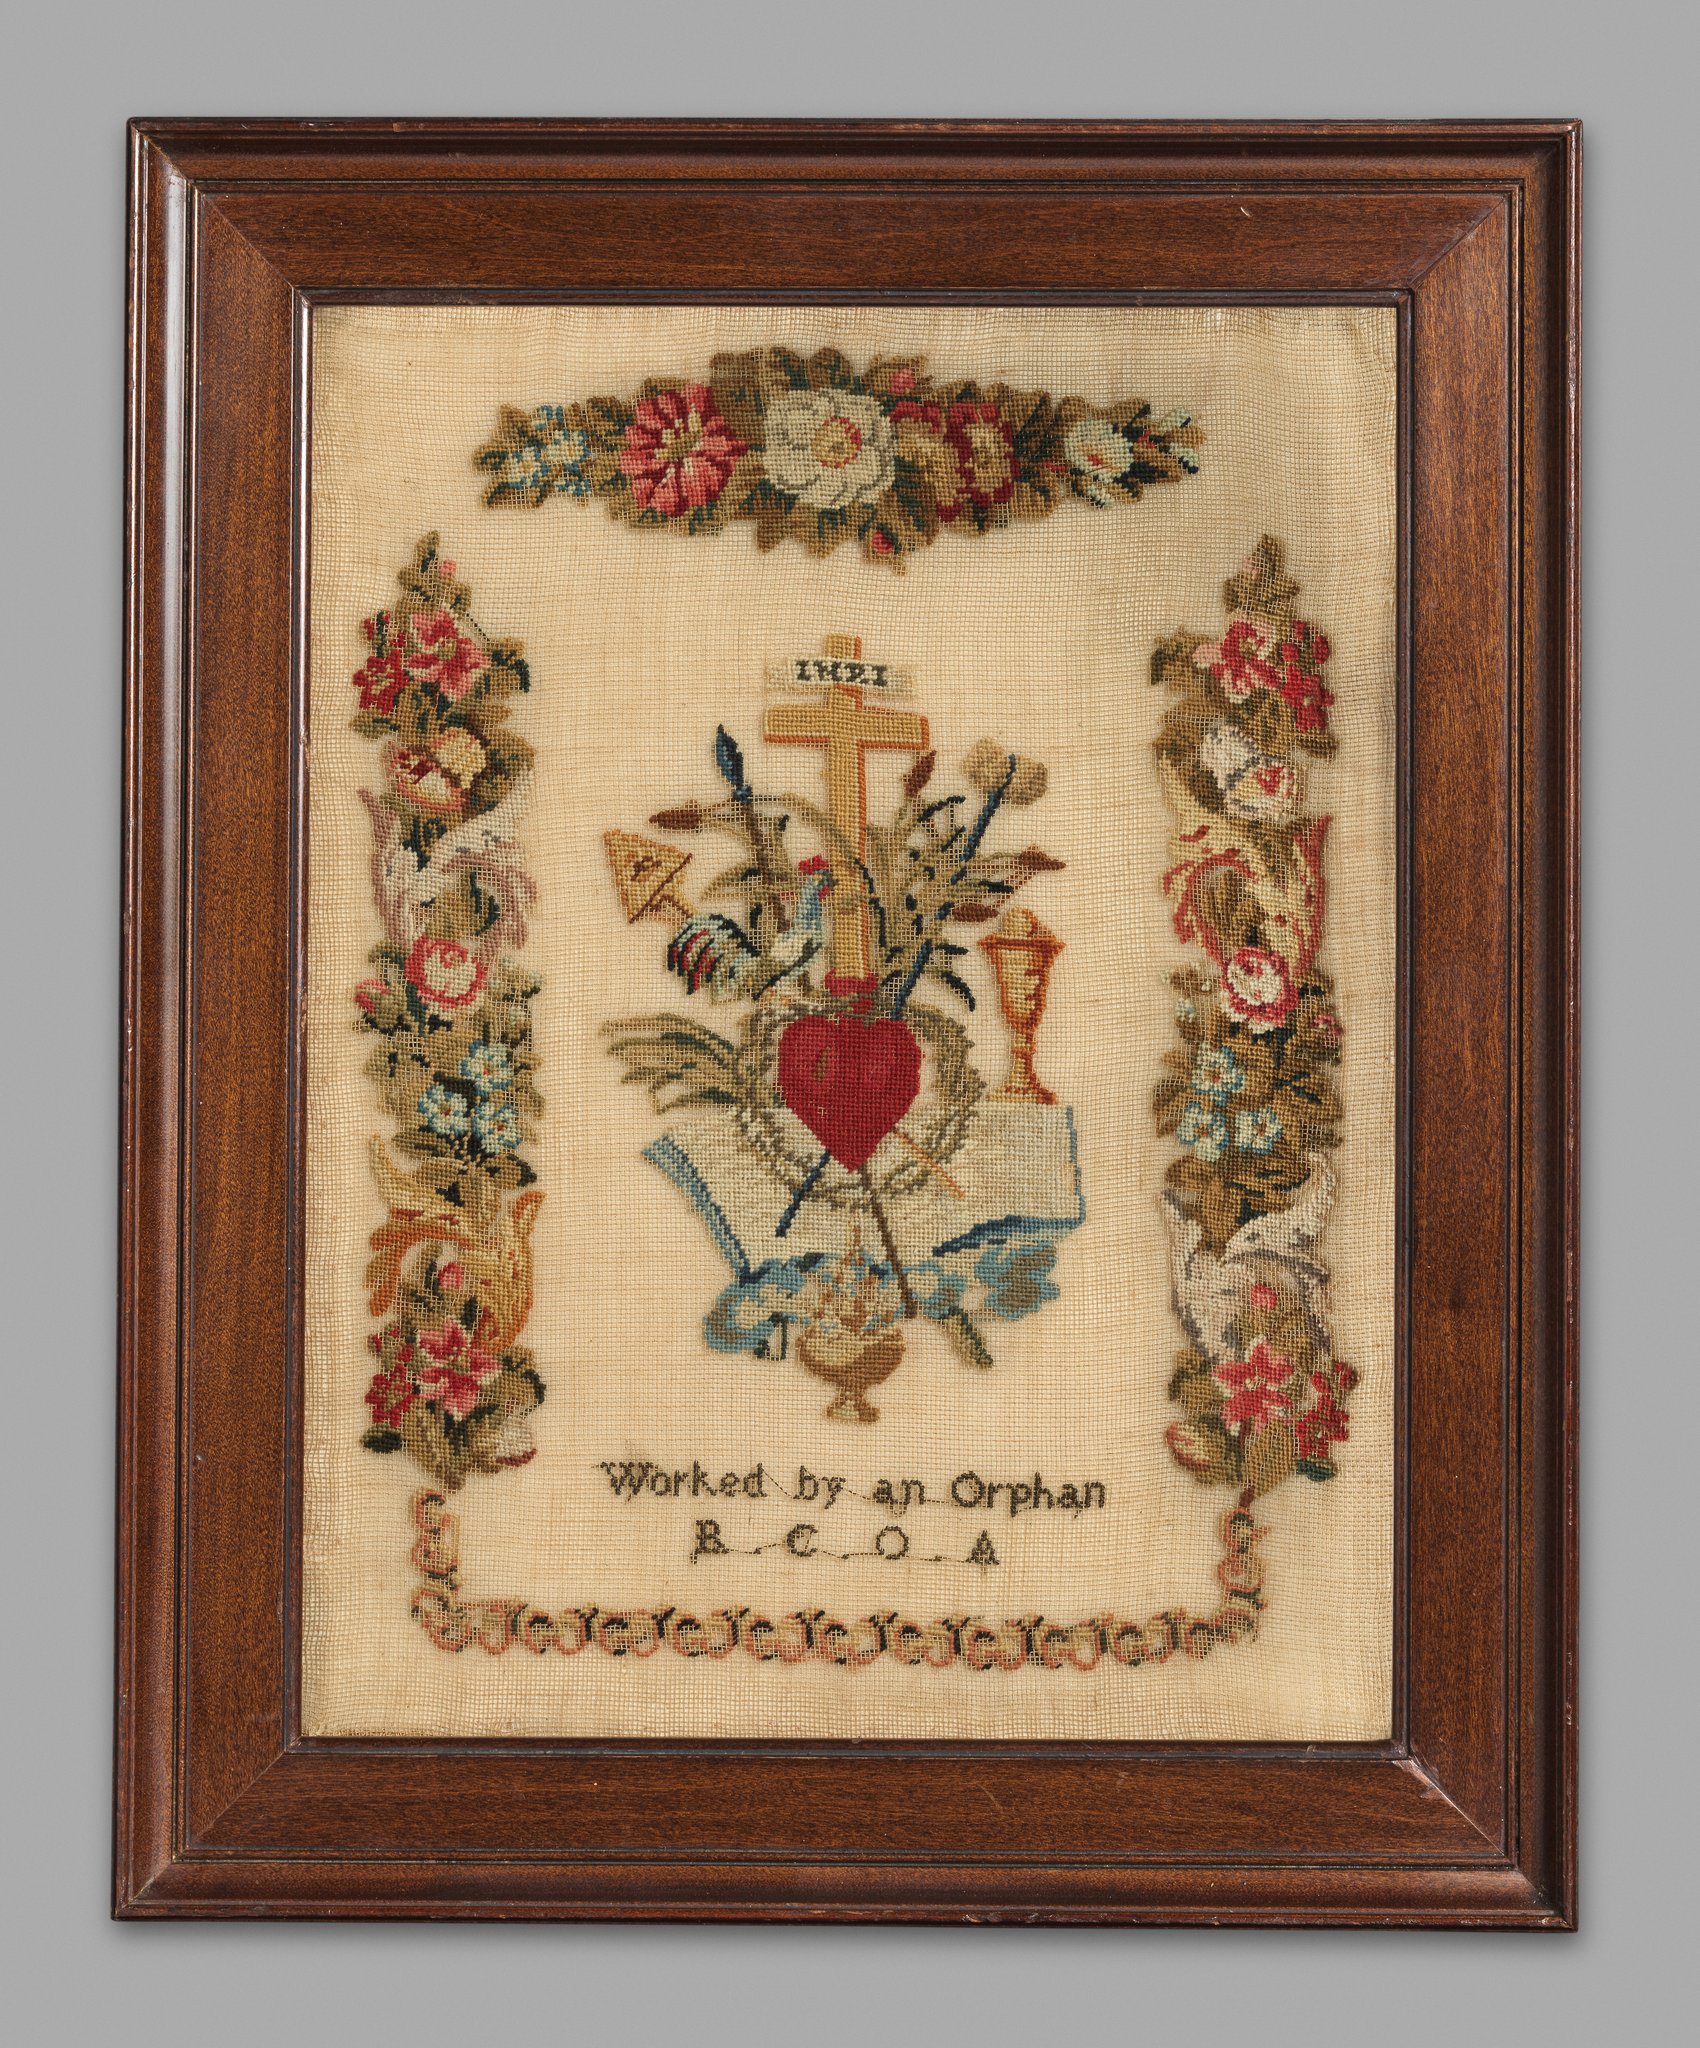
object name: sampler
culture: american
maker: Anonymous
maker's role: maker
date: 1850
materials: linen, silk, wool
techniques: embroidery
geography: united states